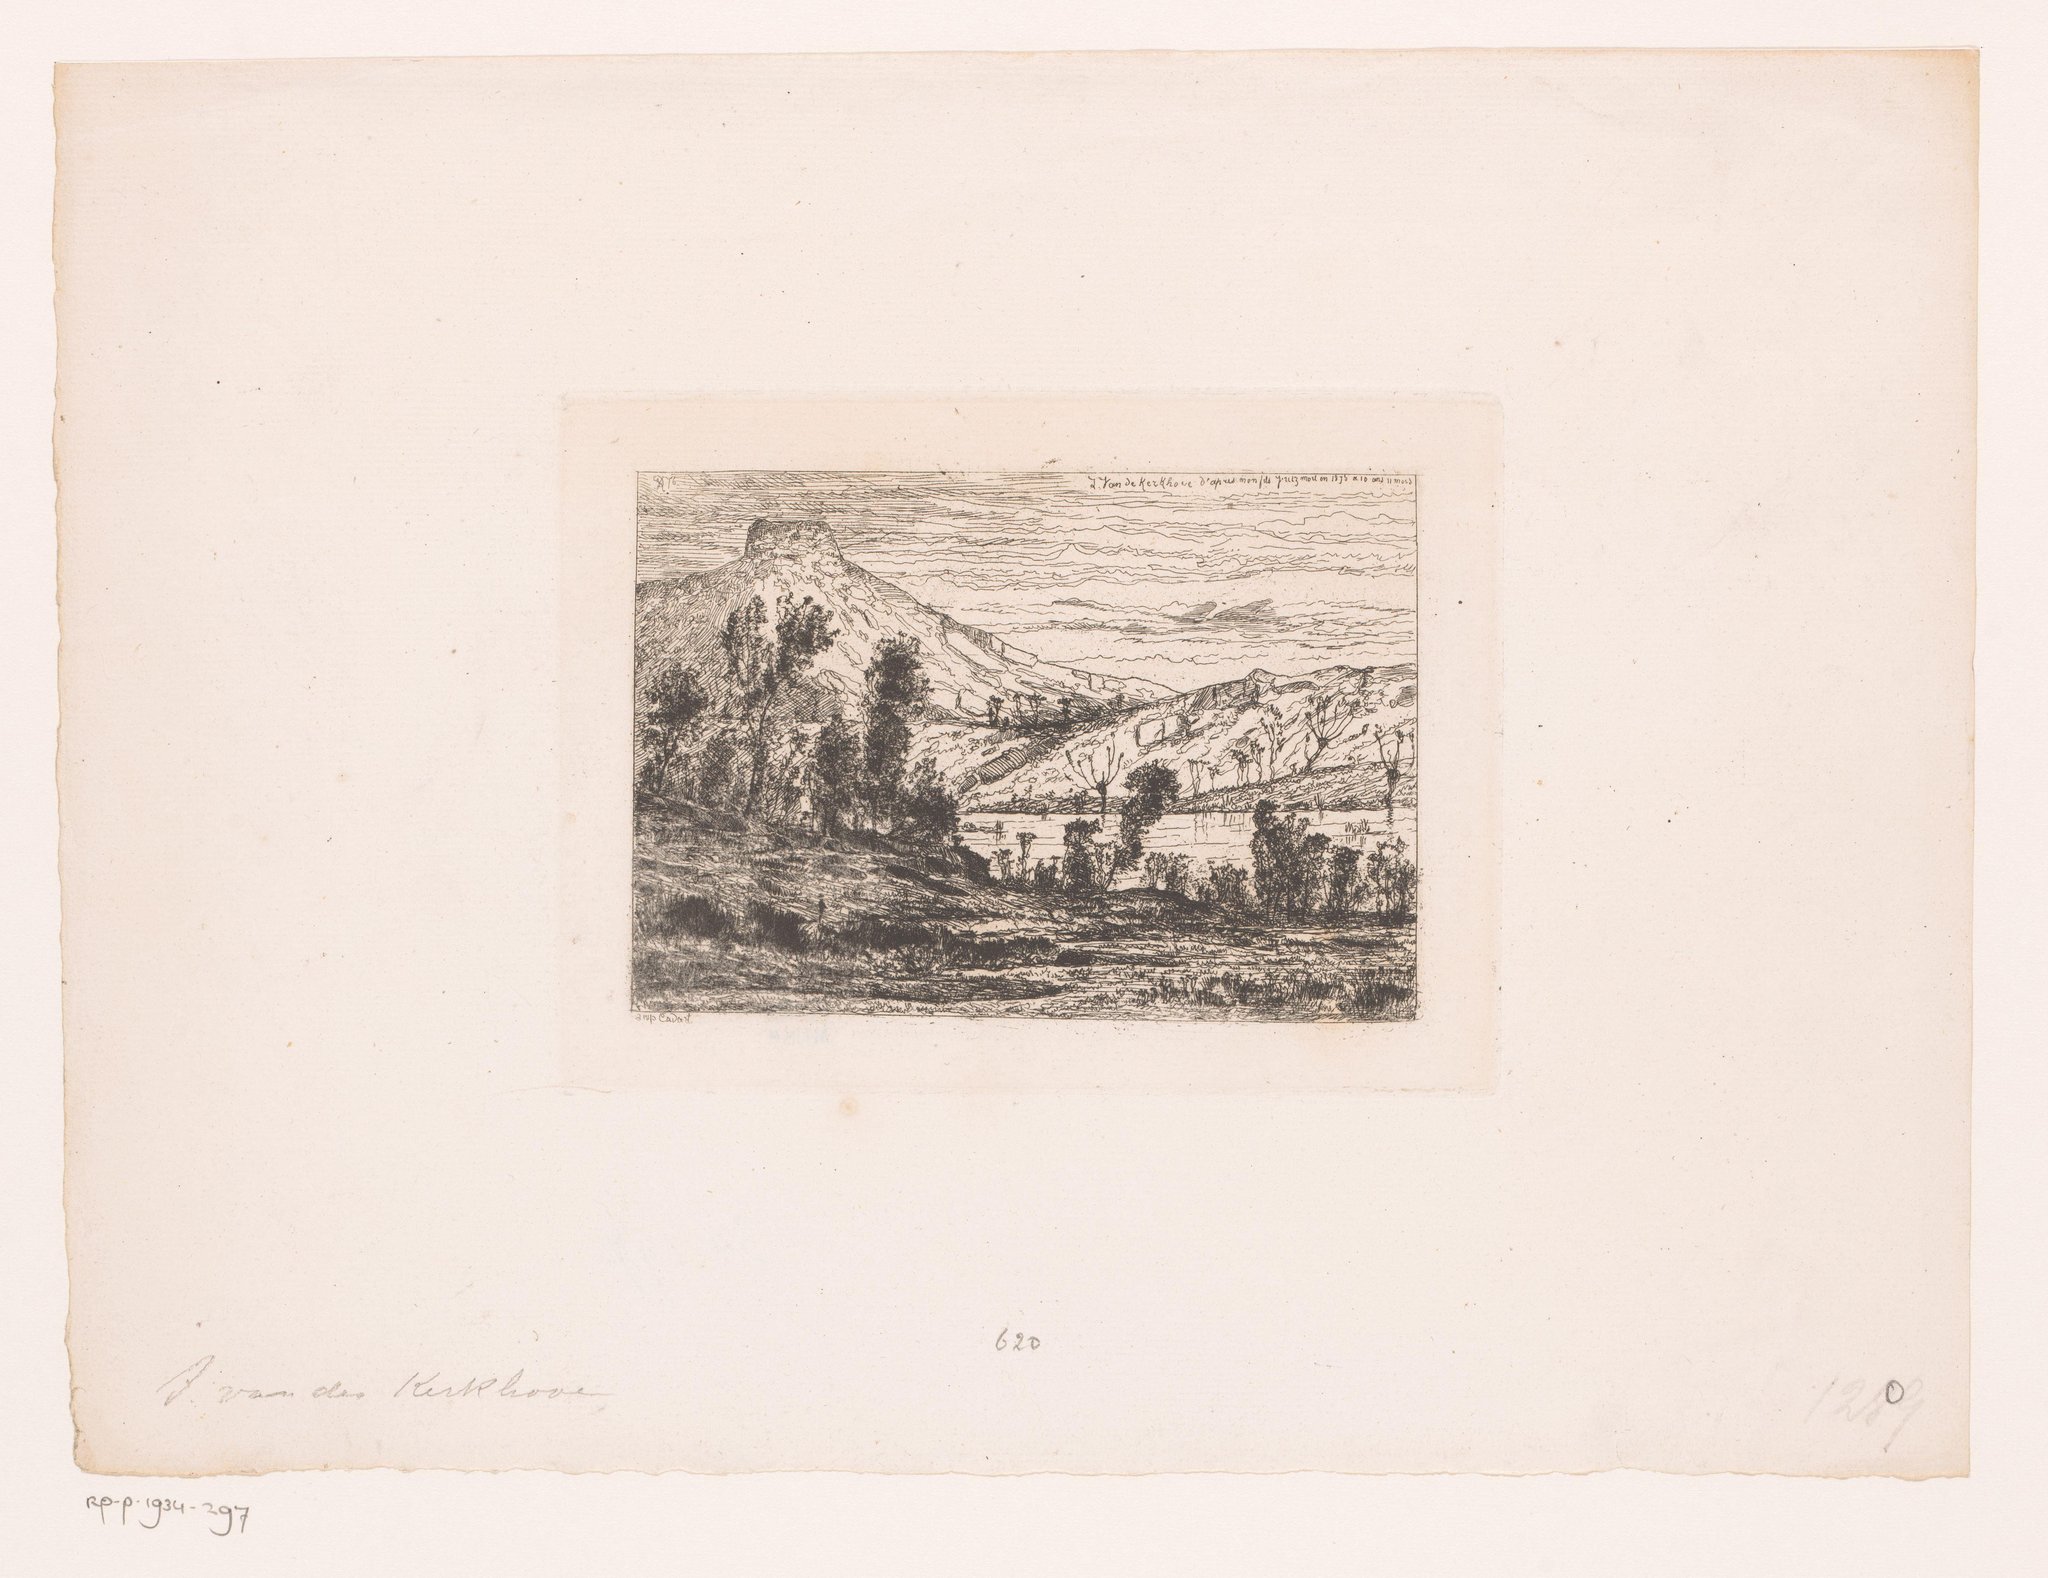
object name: print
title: Rivier in een heuvelachtig landschap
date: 1873-1881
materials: paper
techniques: drypoint, etching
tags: river, (high) hill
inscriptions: collector's mark: Lugt 2166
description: De etsen naar de schilderijen van Frédéric Van de Kerkhove werden na zijn dood door zijn vader en zuster gemaakt en uitgegeven in twee reeksen. De eerste werd in 1877 uitgegeven door het Journal des Beaux-Arts et de la Littérature: Cahier de 25 Eaux-fortes d'après Frédéric van de Kerkhove, gravées par son père et sa sœur. De tweede reeks van 126 etsen werd, ook in 1877, in Parijs uitgegeven bij A. Lévy onder de titel Cent eaux-fortes gravées par J. Van de Kerkhove d'après les tableaux de Frédéric Van de Kerkhove, mort en 1873 à l'âge de 10 ans et 11 mois.